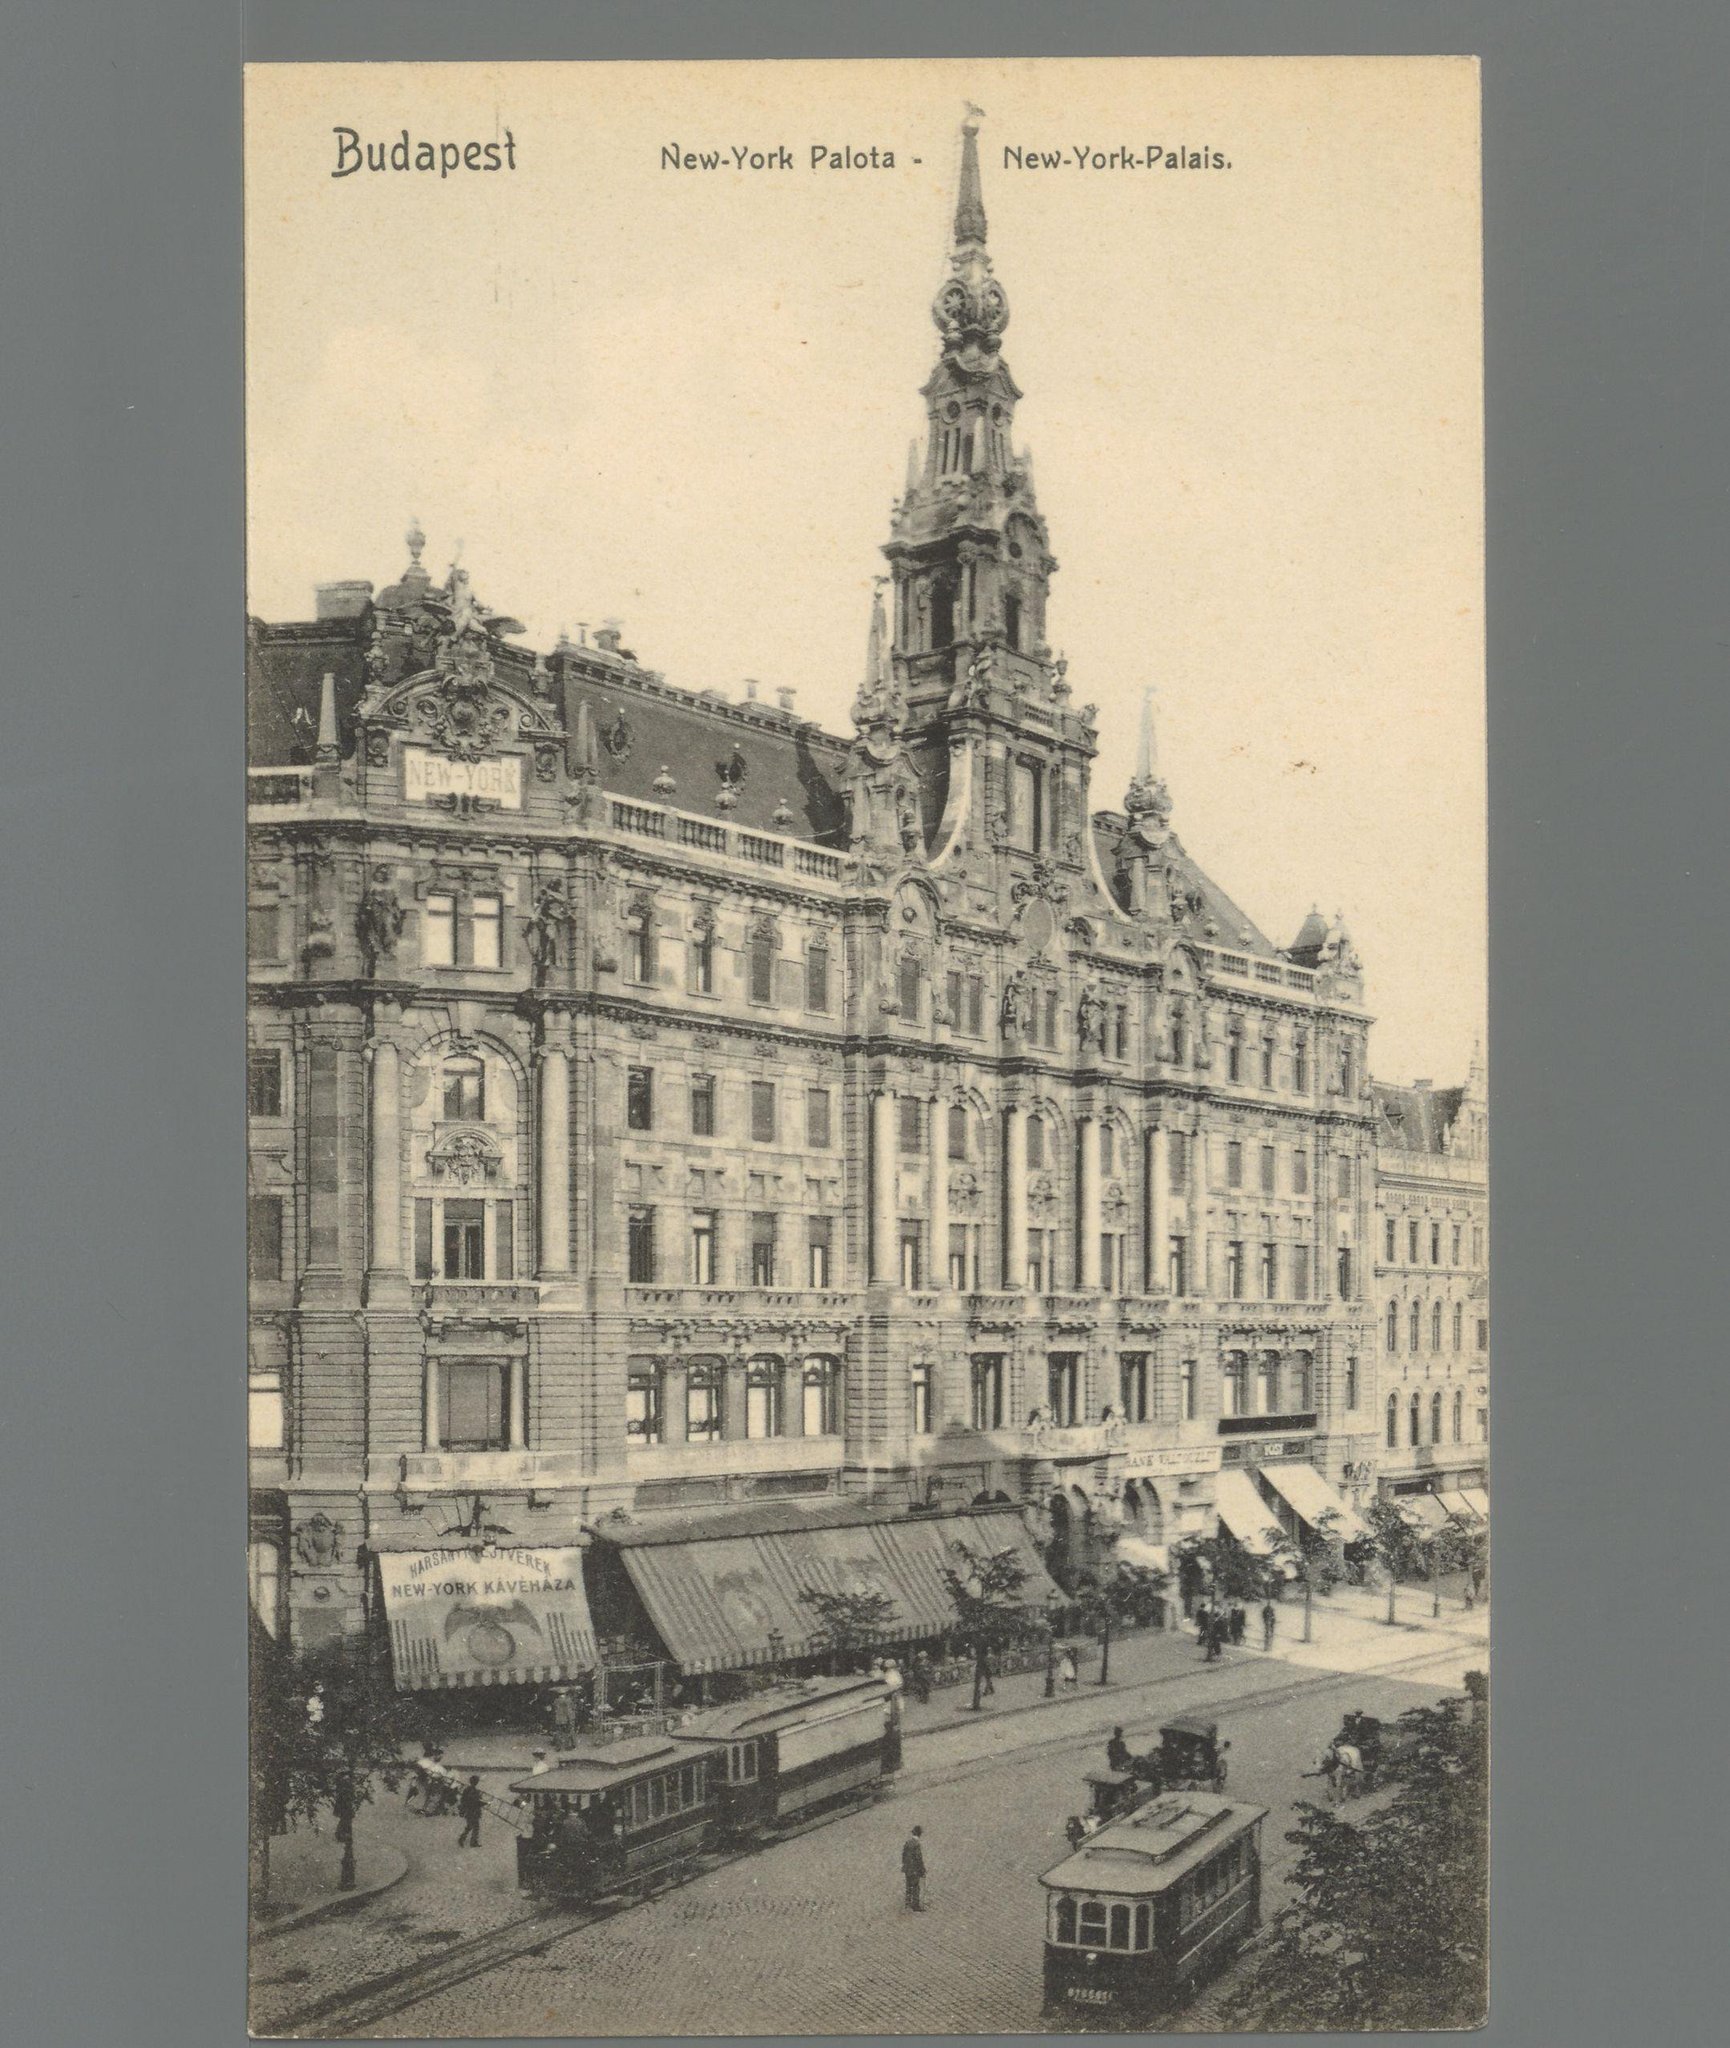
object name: ansichtkaart, prentbriefkaart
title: Budapest. New-York Palota / New-York-Palais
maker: Anonymous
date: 1905-1930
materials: cardboard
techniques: photograph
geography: budapest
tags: edifice, e.g.: public building, department store